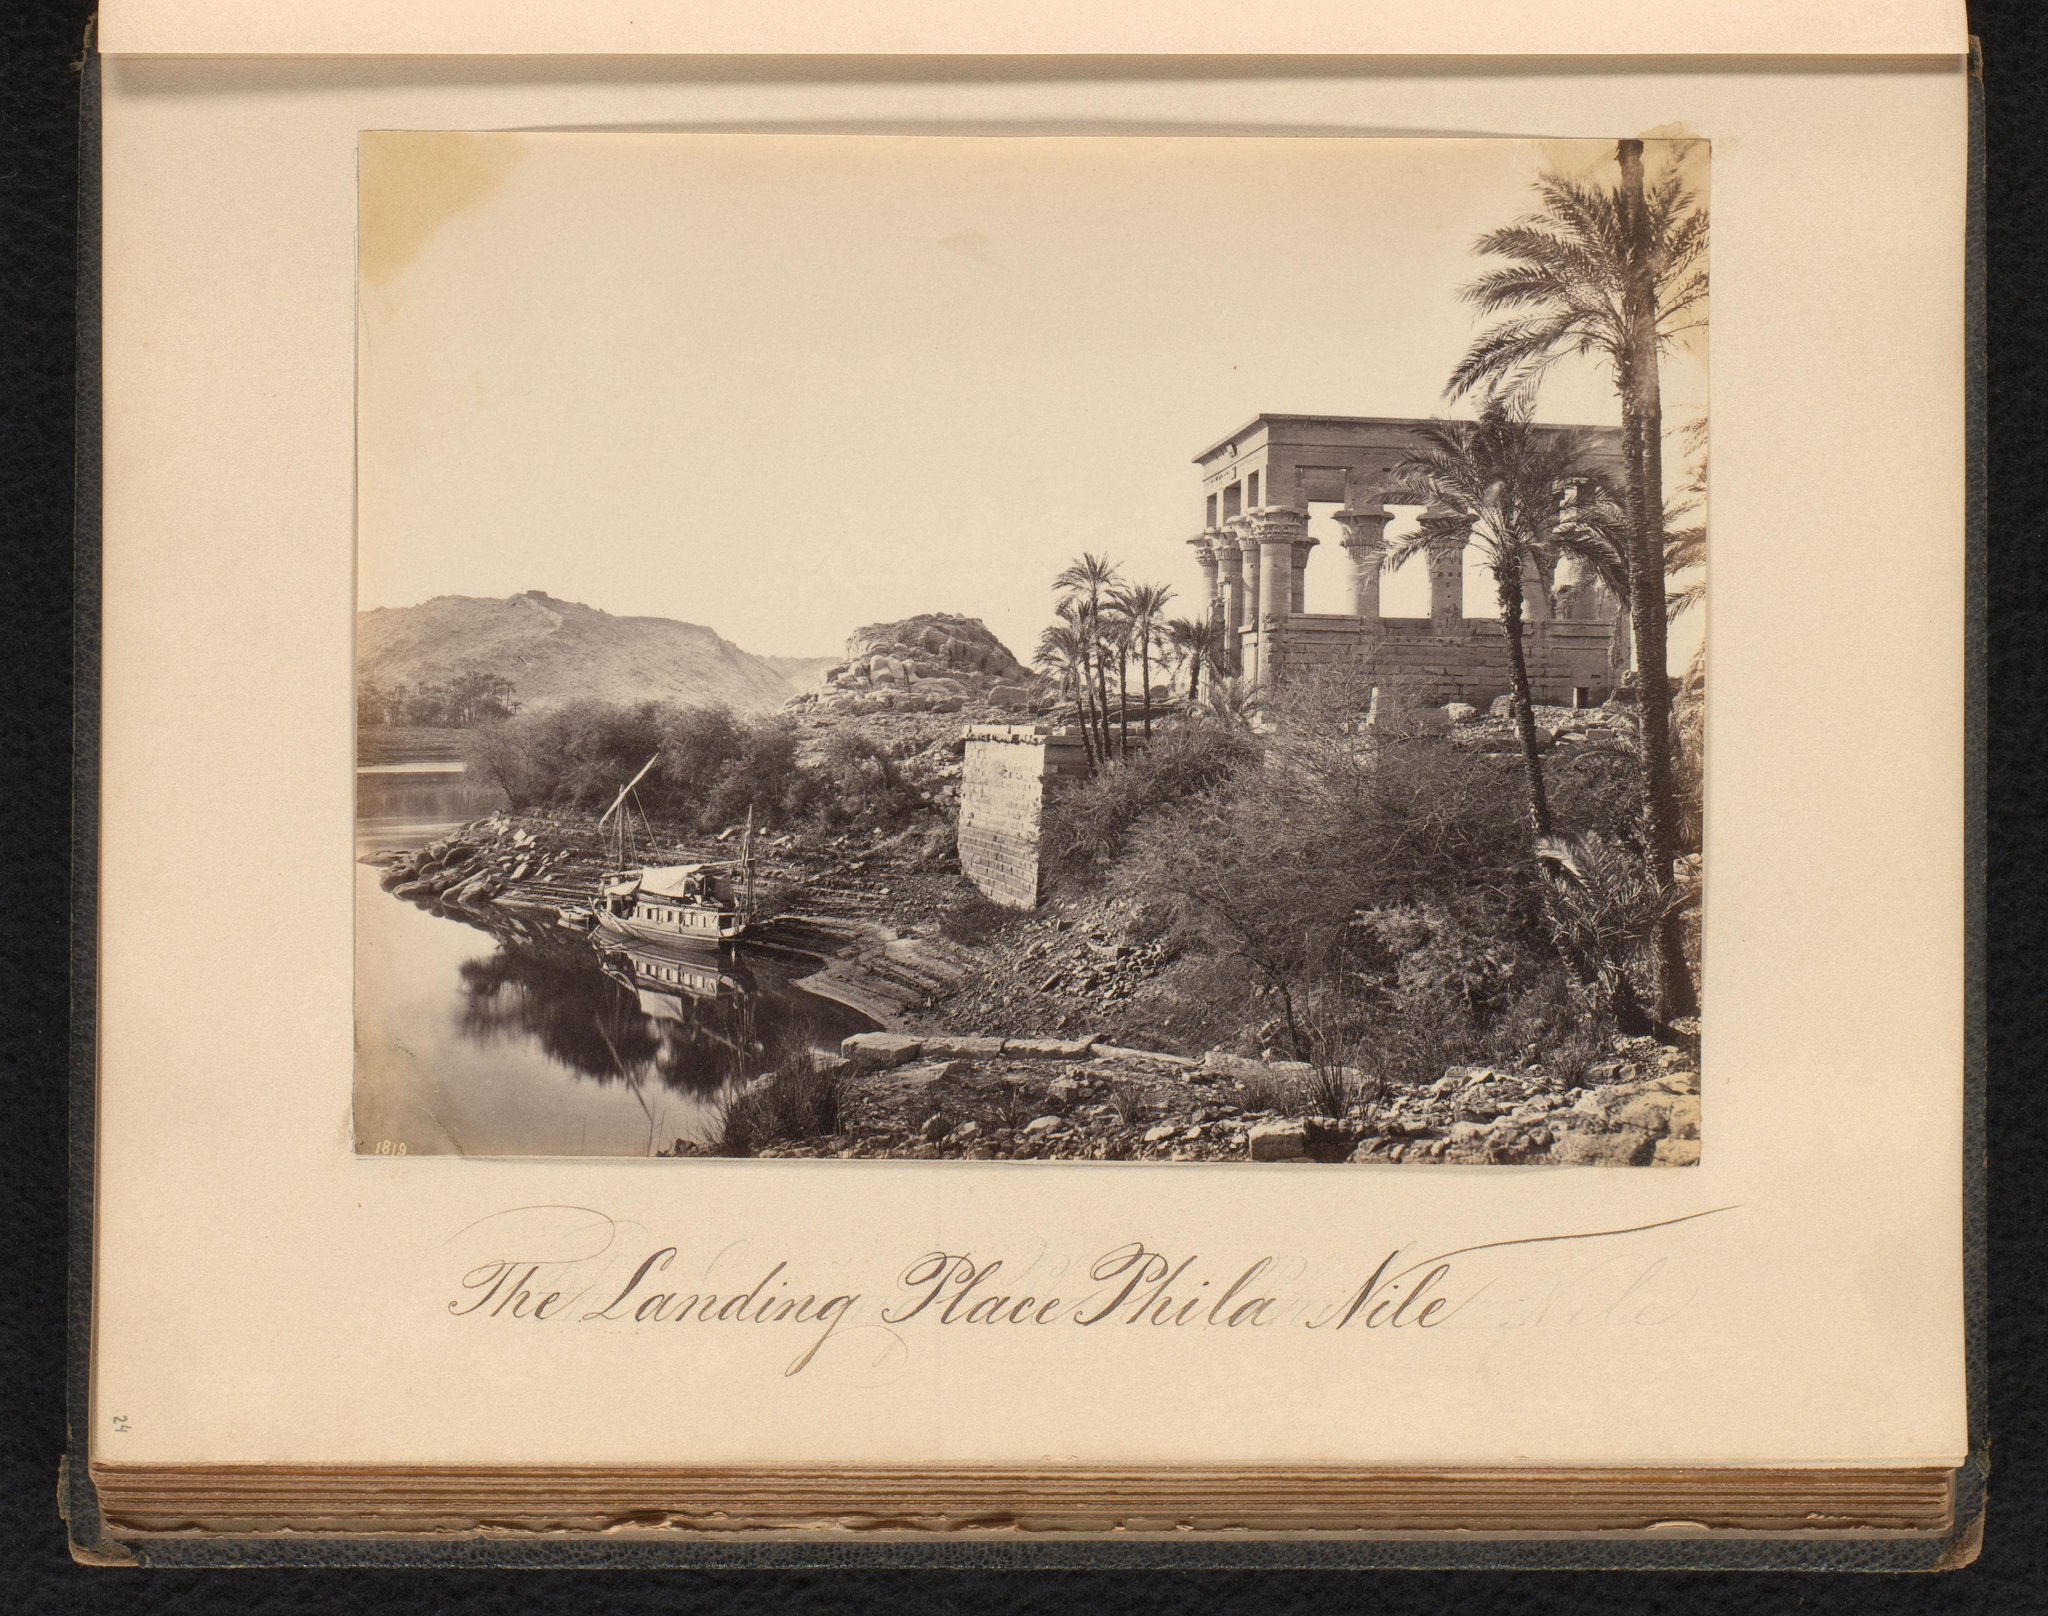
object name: album leaf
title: The Landing Place Phila Nile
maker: Anonymous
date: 1860-1880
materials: paper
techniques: albumen print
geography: philae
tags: island, temple, shrine ~ roman religion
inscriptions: number: ‘1819’